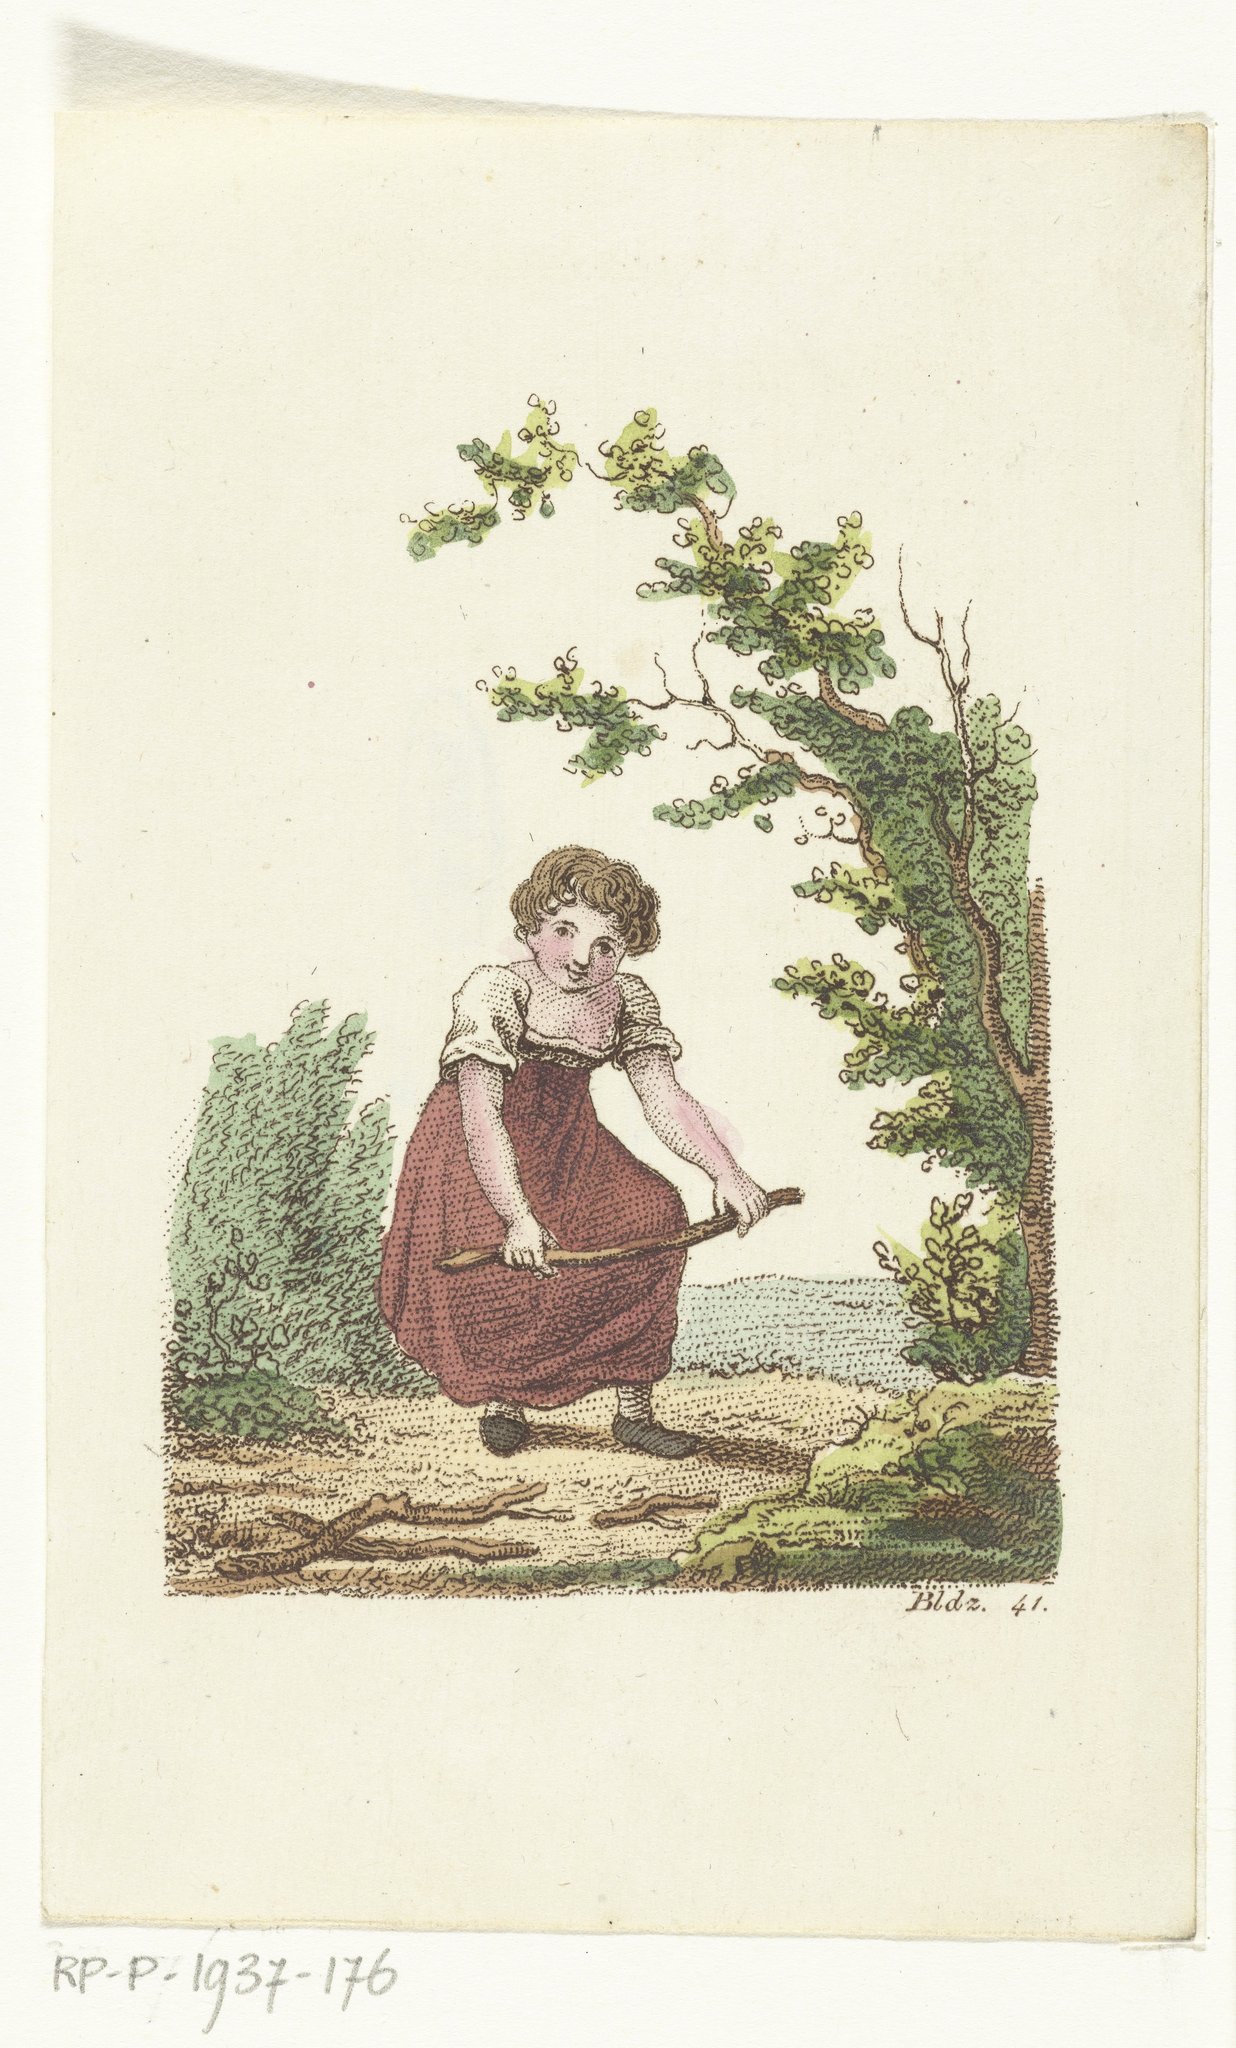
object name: print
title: De moederlooze Maria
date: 1807-1823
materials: paper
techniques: etching, hand coloring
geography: amsterdam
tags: woodgathering, woodgatherer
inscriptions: collector's mark: Lugt 2228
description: Boekillustratie voor: Anna Barbara van Meerten-Schilperoort, De moederlooze Maria, een verhaal waaruit de lieve kinderen kunnen leeren, dat braafheid en deugd in iederen stand hare belooning vinden, G.J.A. Beijerinck (uitgever), Amsterdam 1823, illustratie bij tekst op p. 41.